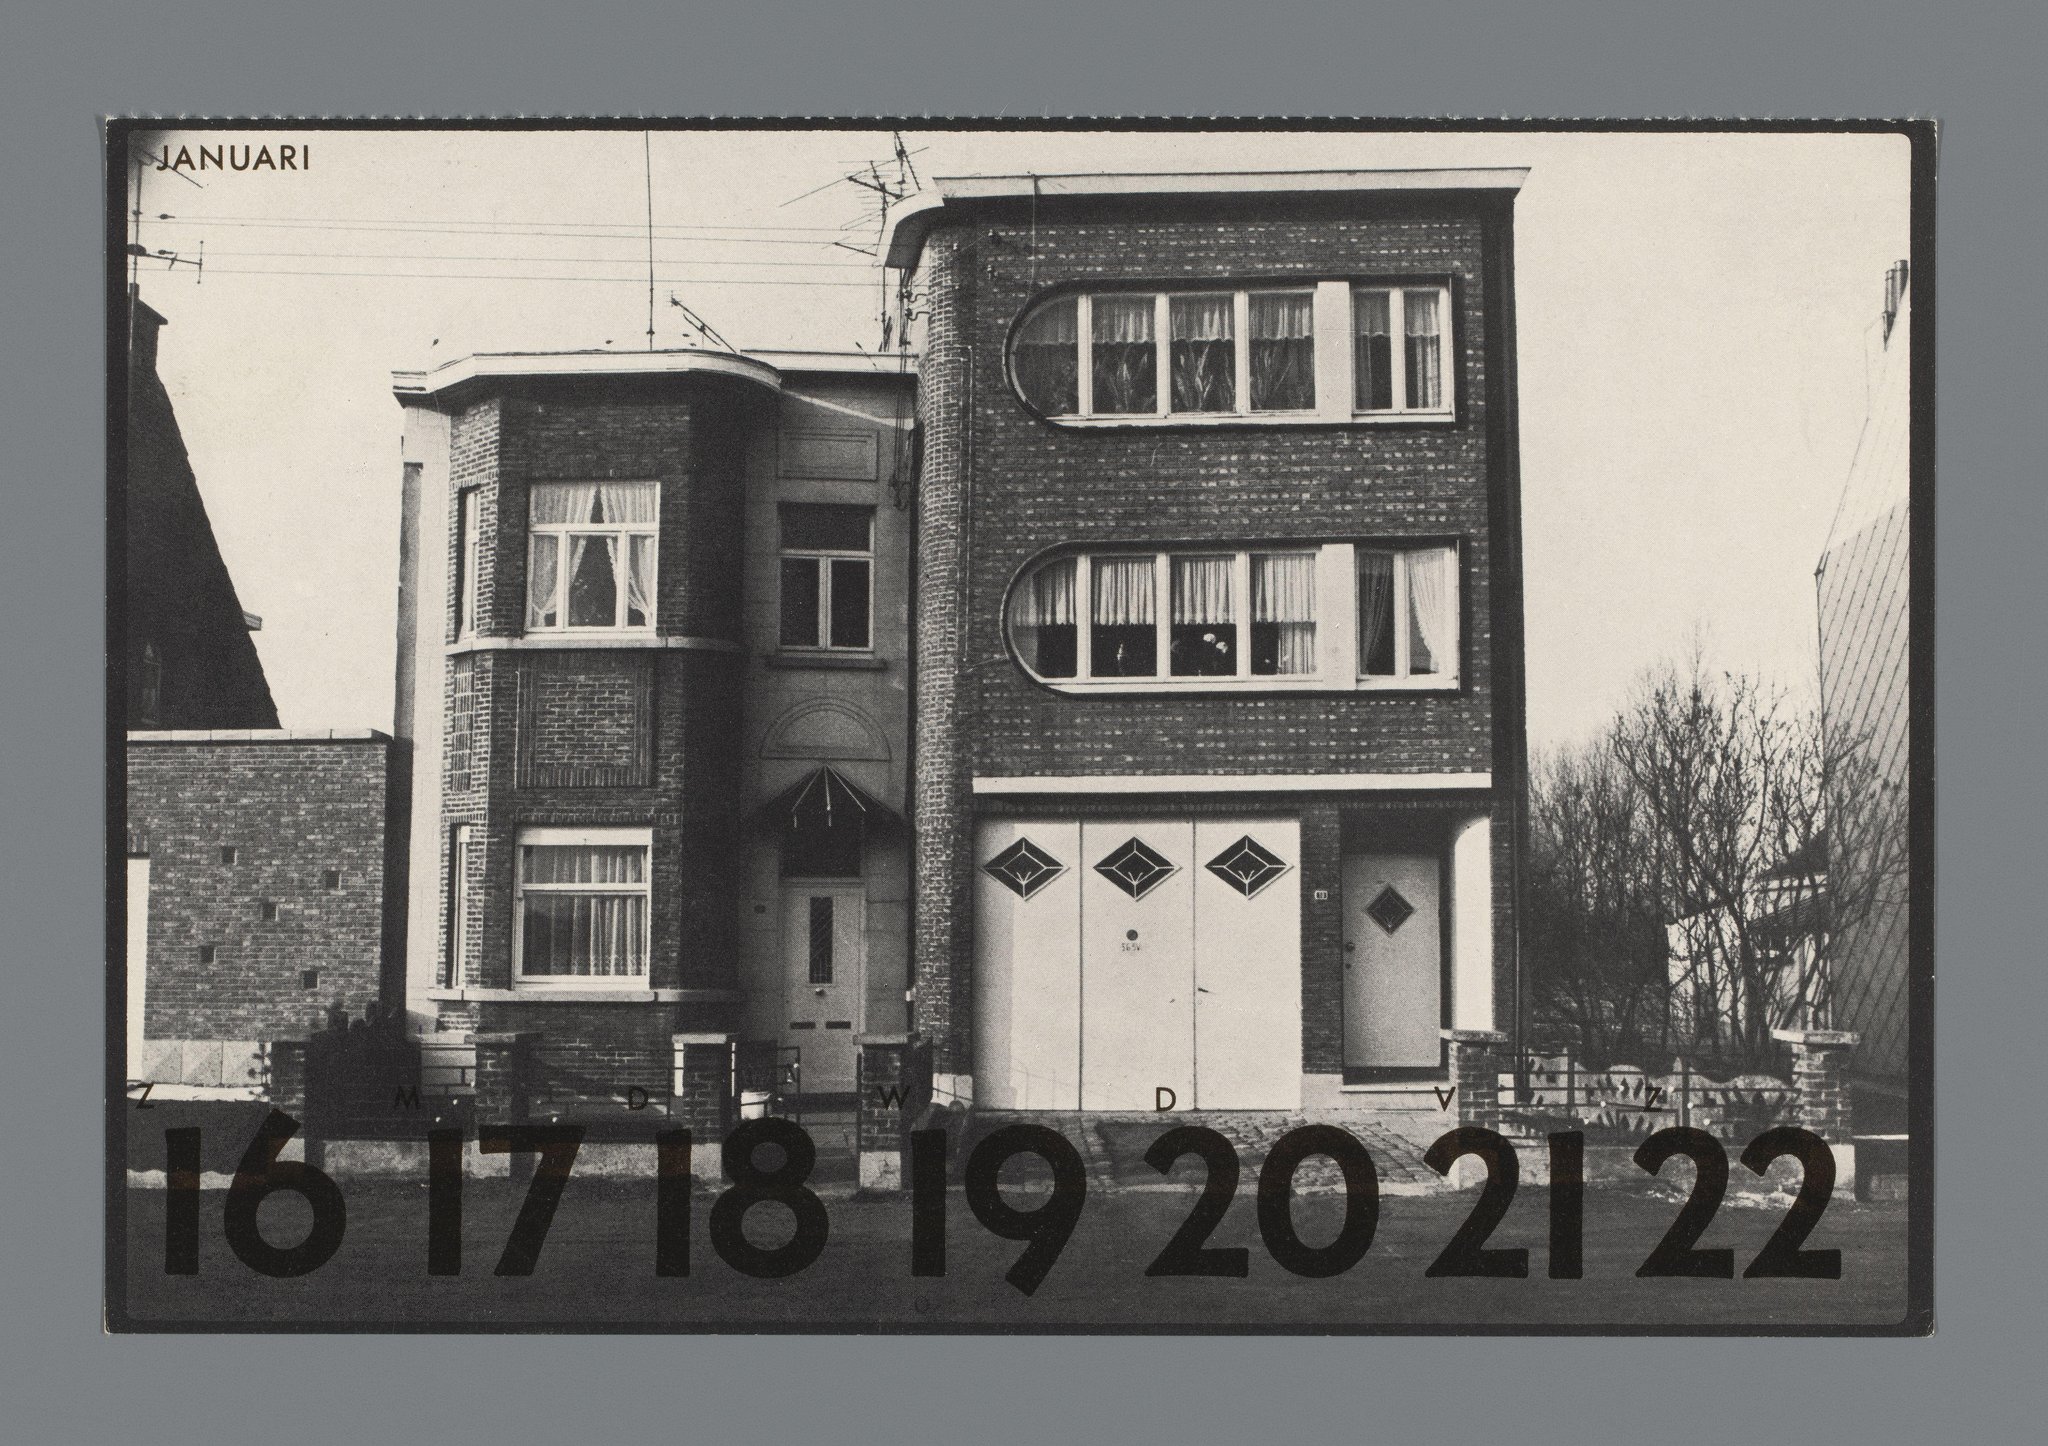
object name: photograph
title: België. Huizen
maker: Anonymous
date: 1900-1950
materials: paper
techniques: offset printed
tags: belgium